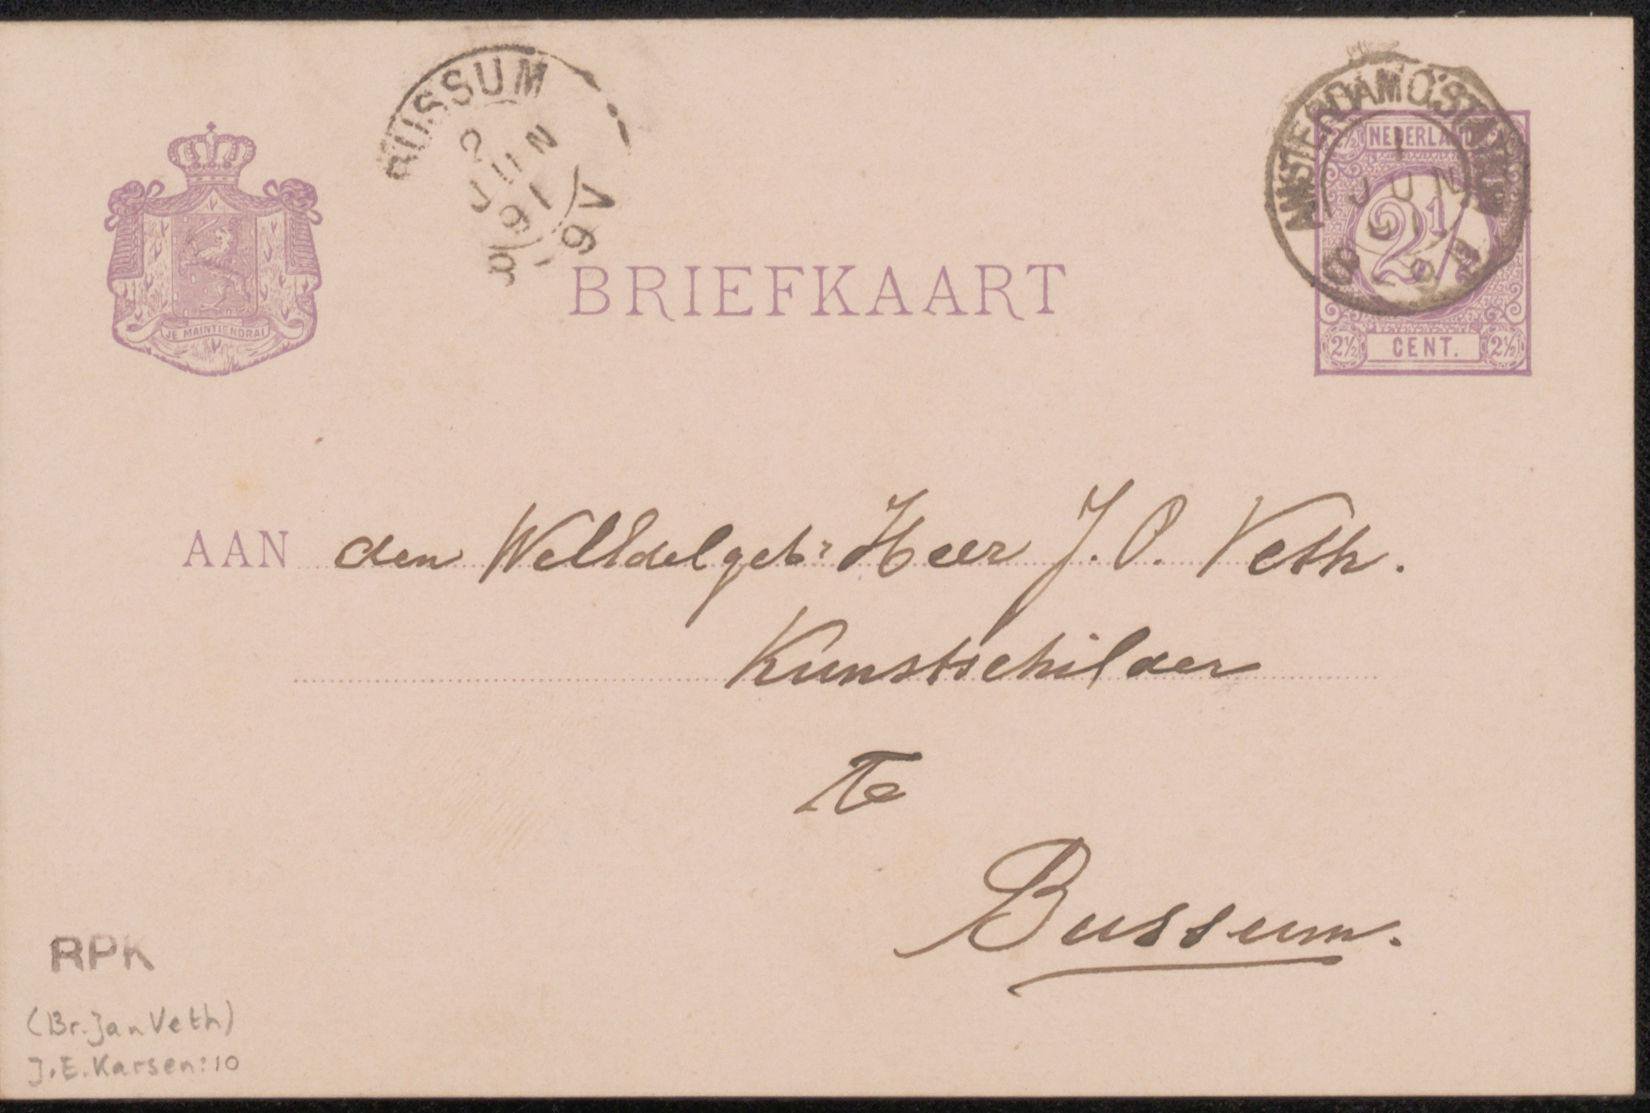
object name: postcard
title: Briefkaart aan Jan Veth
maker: eduard karsen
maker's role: draughtsman, painter, print maker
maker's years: 1860-1941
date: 1891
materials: cardboard, ink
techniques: pen, writing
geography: amsterdam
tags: dordrecht, designer, jan veth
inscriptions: collector's mark: ‘RPK’